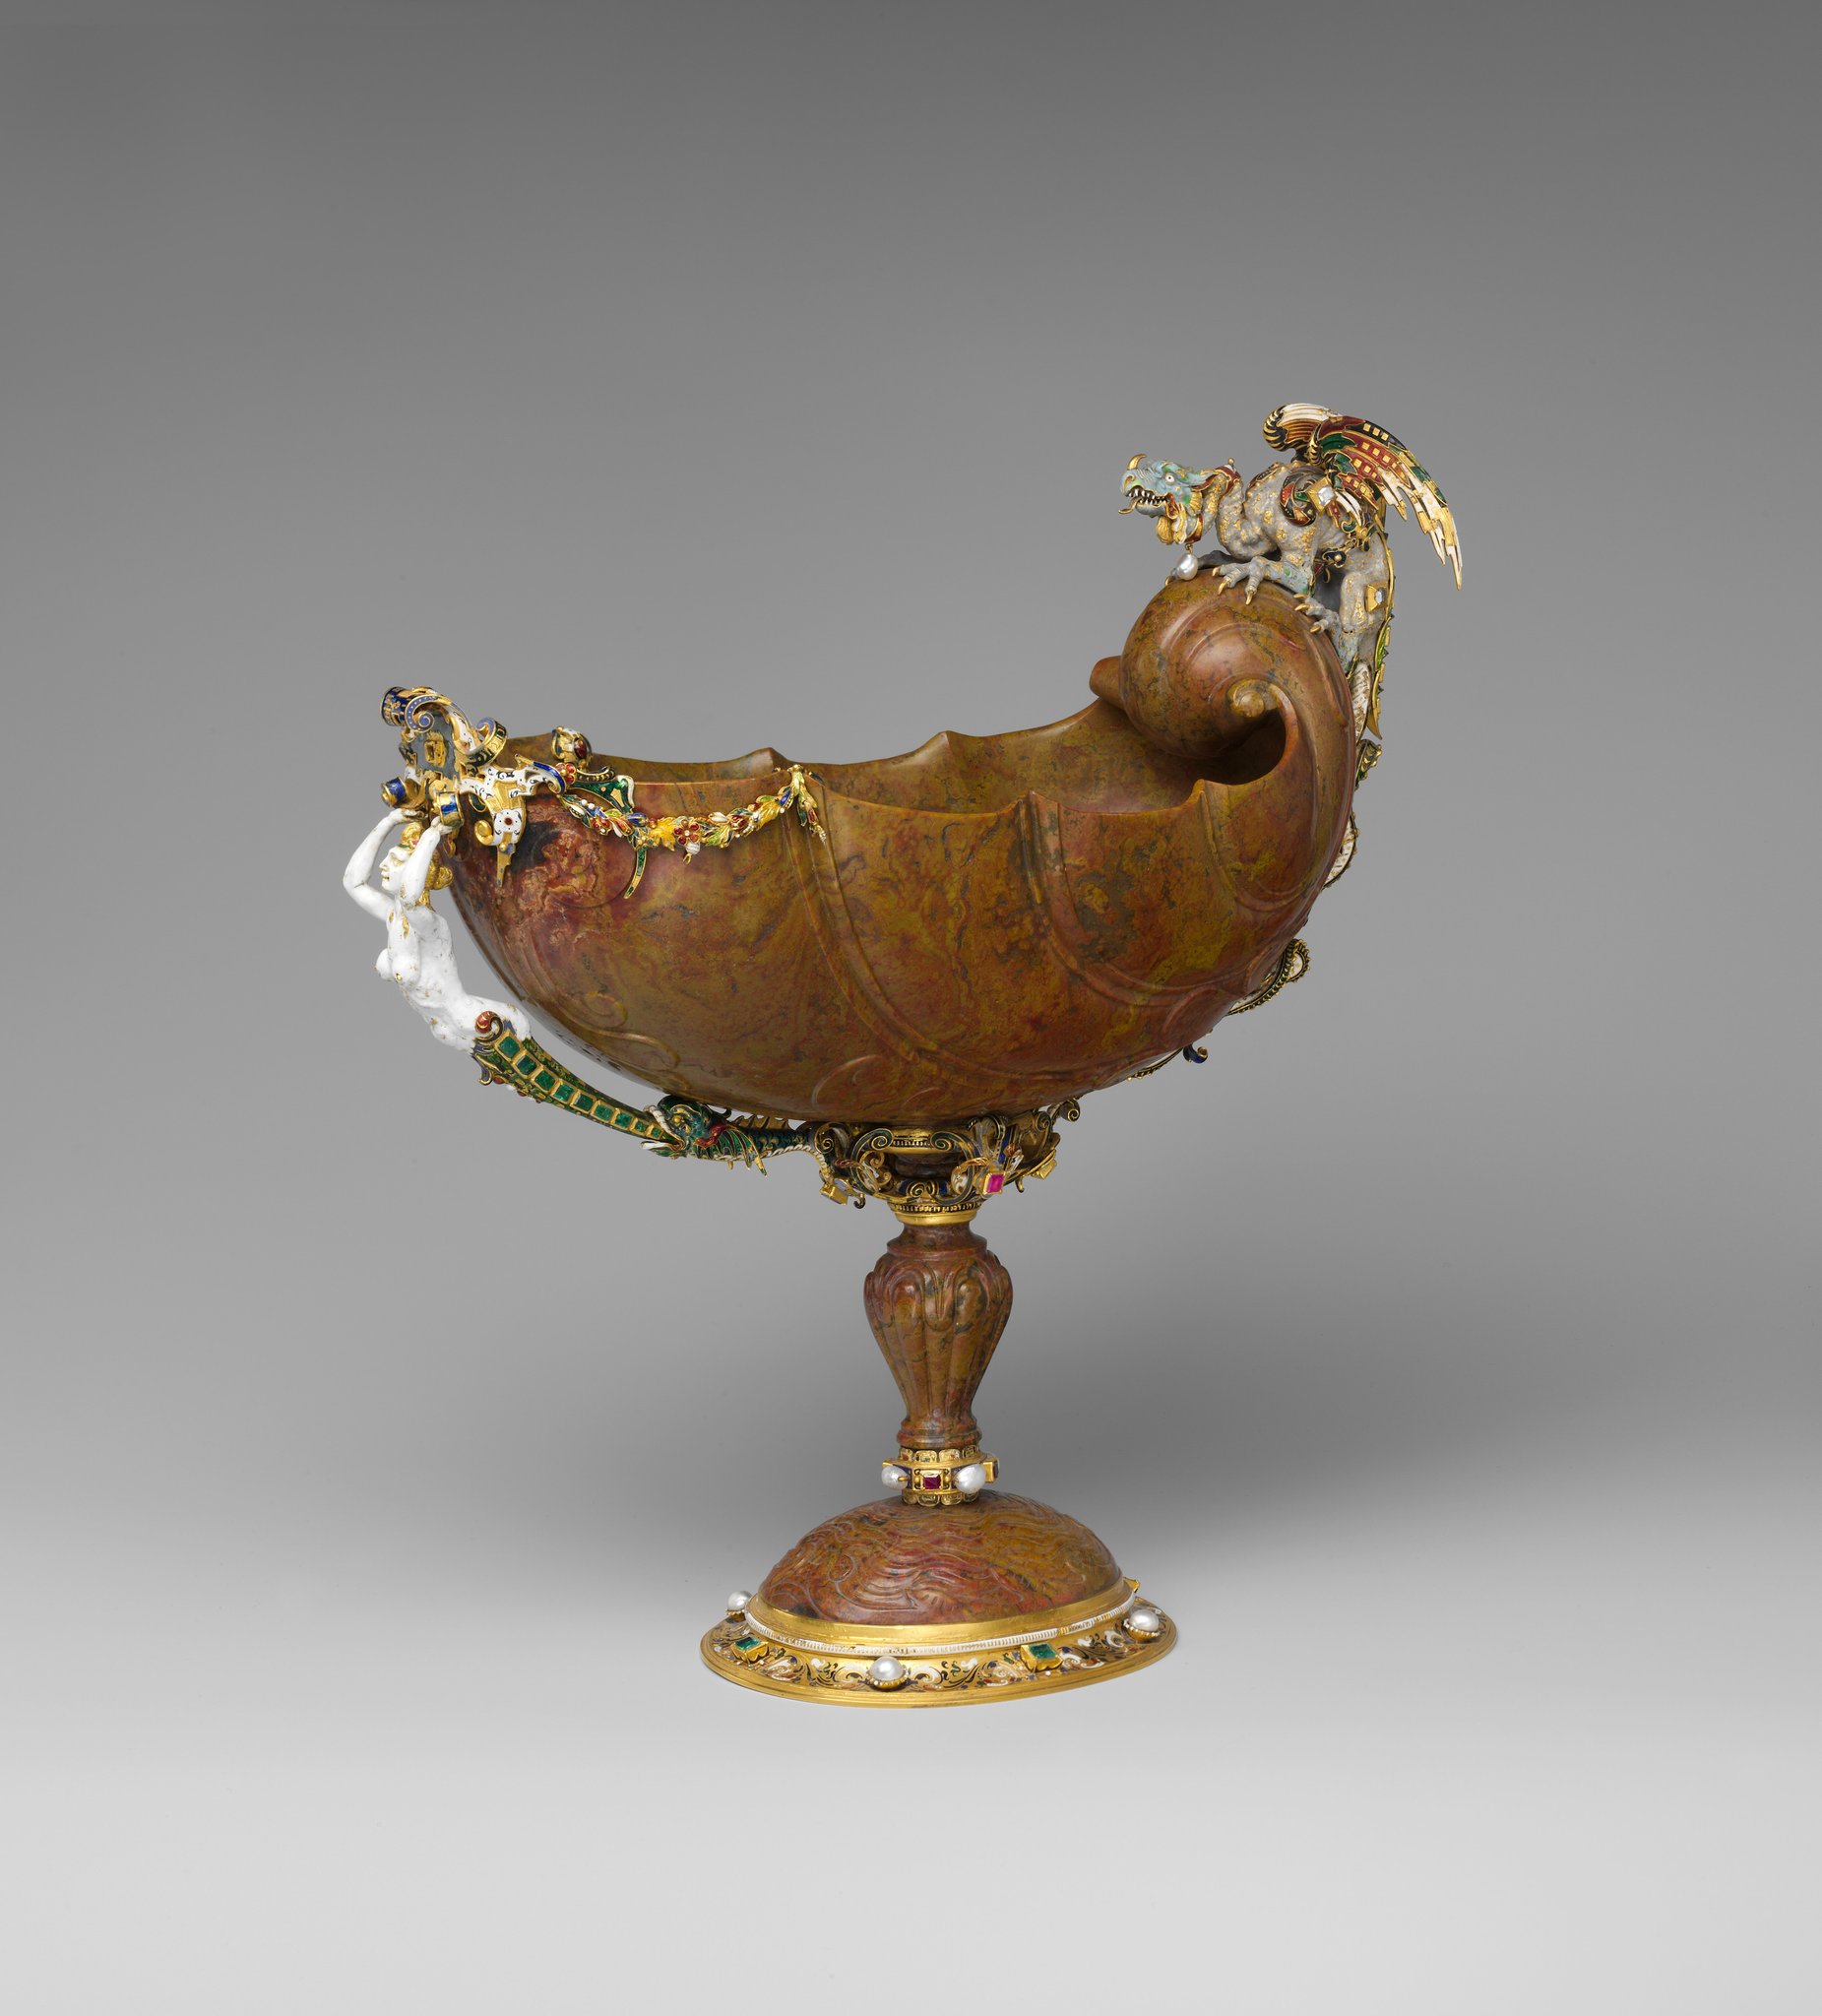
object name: standing cup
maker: reinhold vasters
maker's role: designer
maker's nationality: german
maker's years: 1827-1909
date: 1870-1890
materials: gold, jasper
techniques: enamel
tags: dragons,mermaids